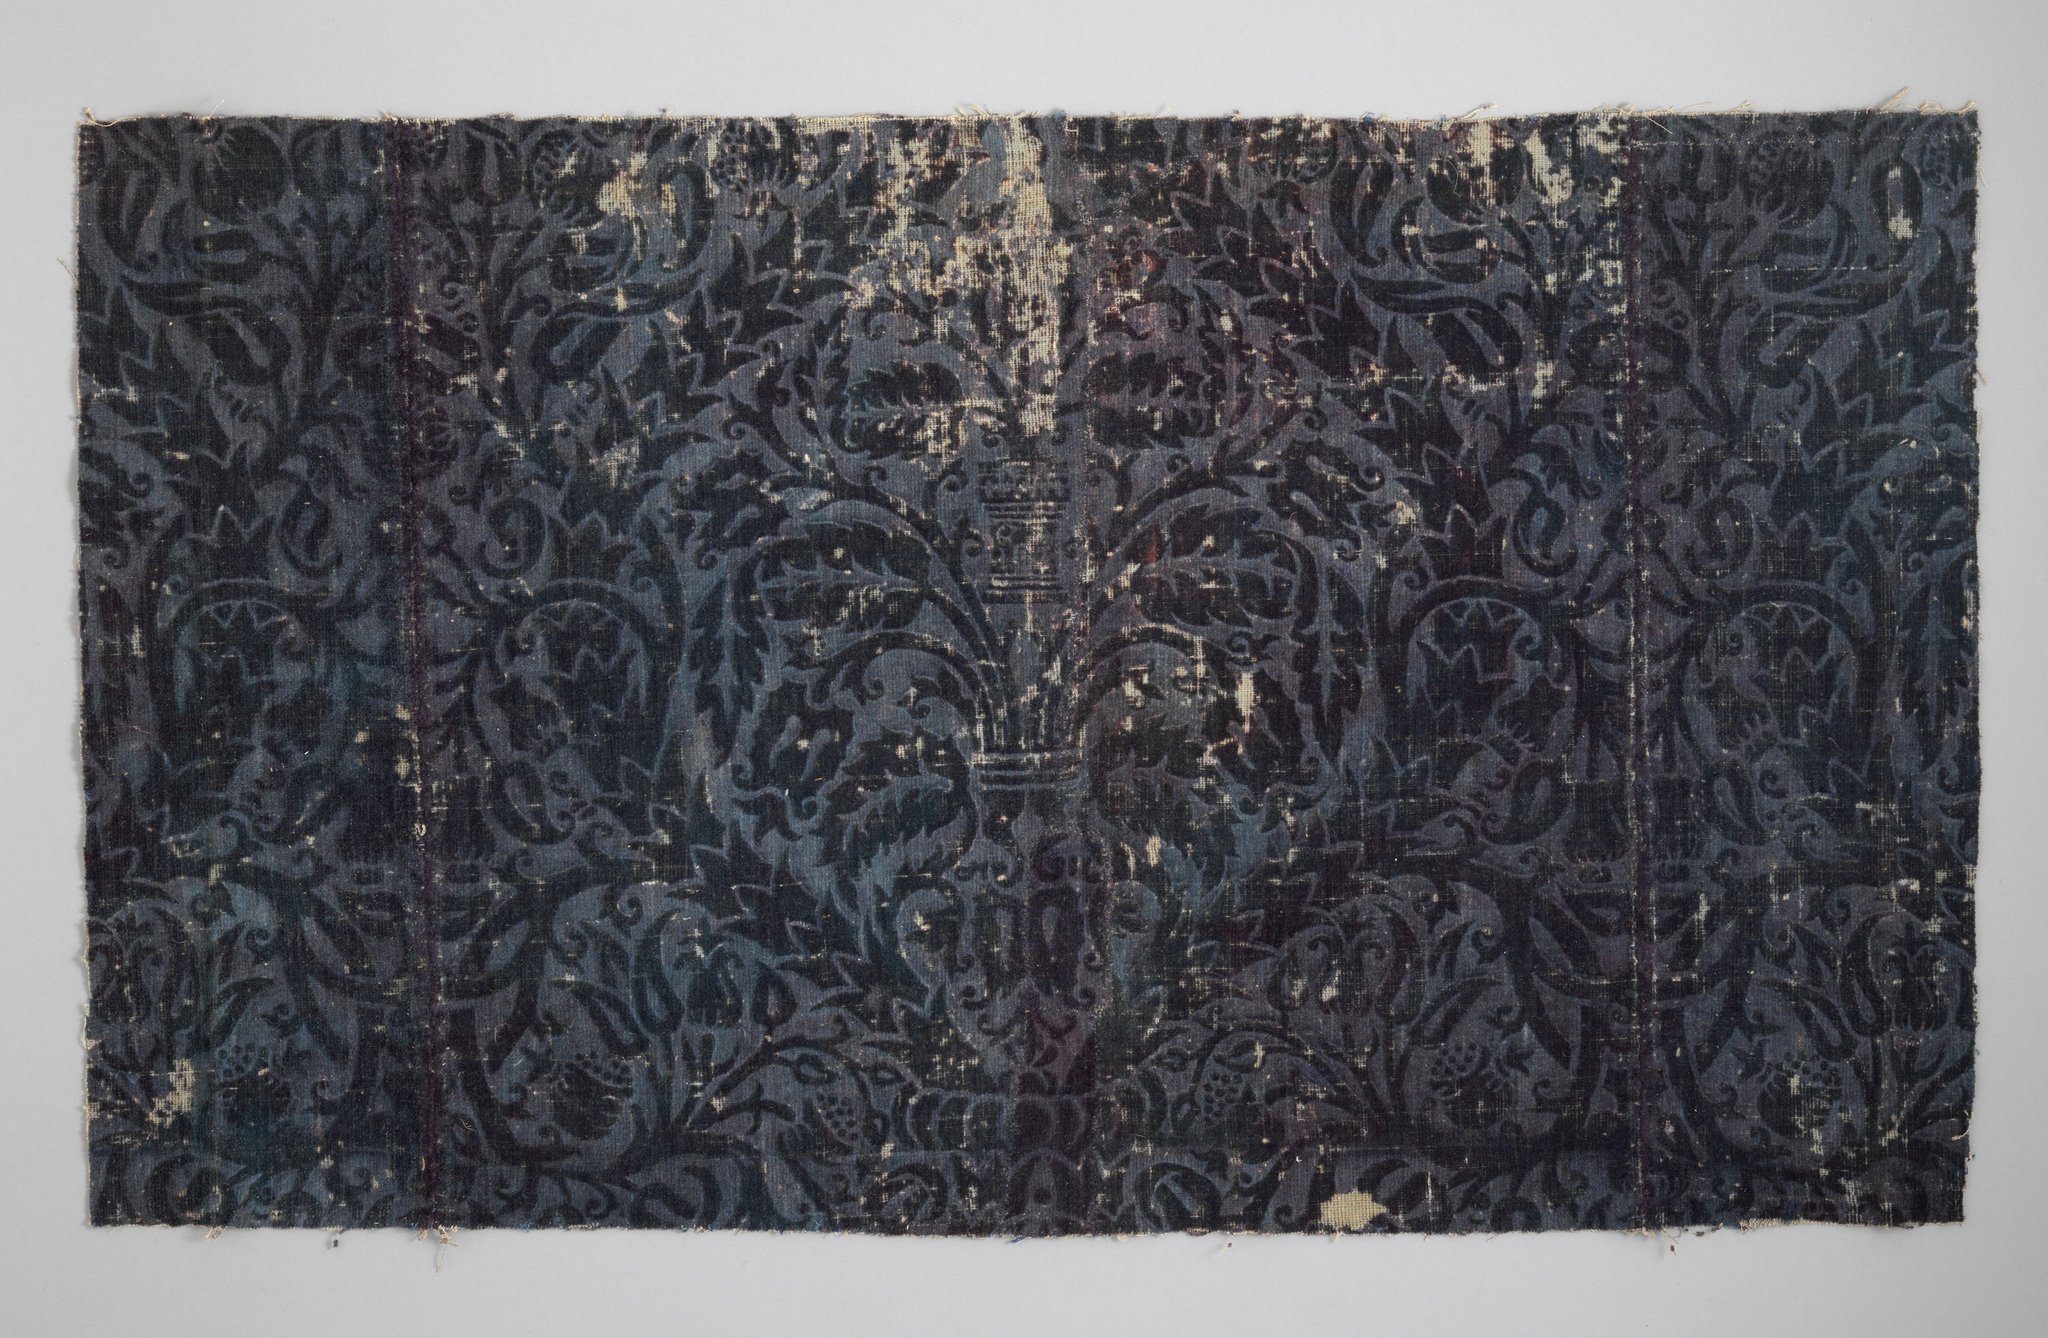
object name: piece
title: Fragment with Sempervivum tectorum motif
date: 1501-1600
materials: fiber, wool